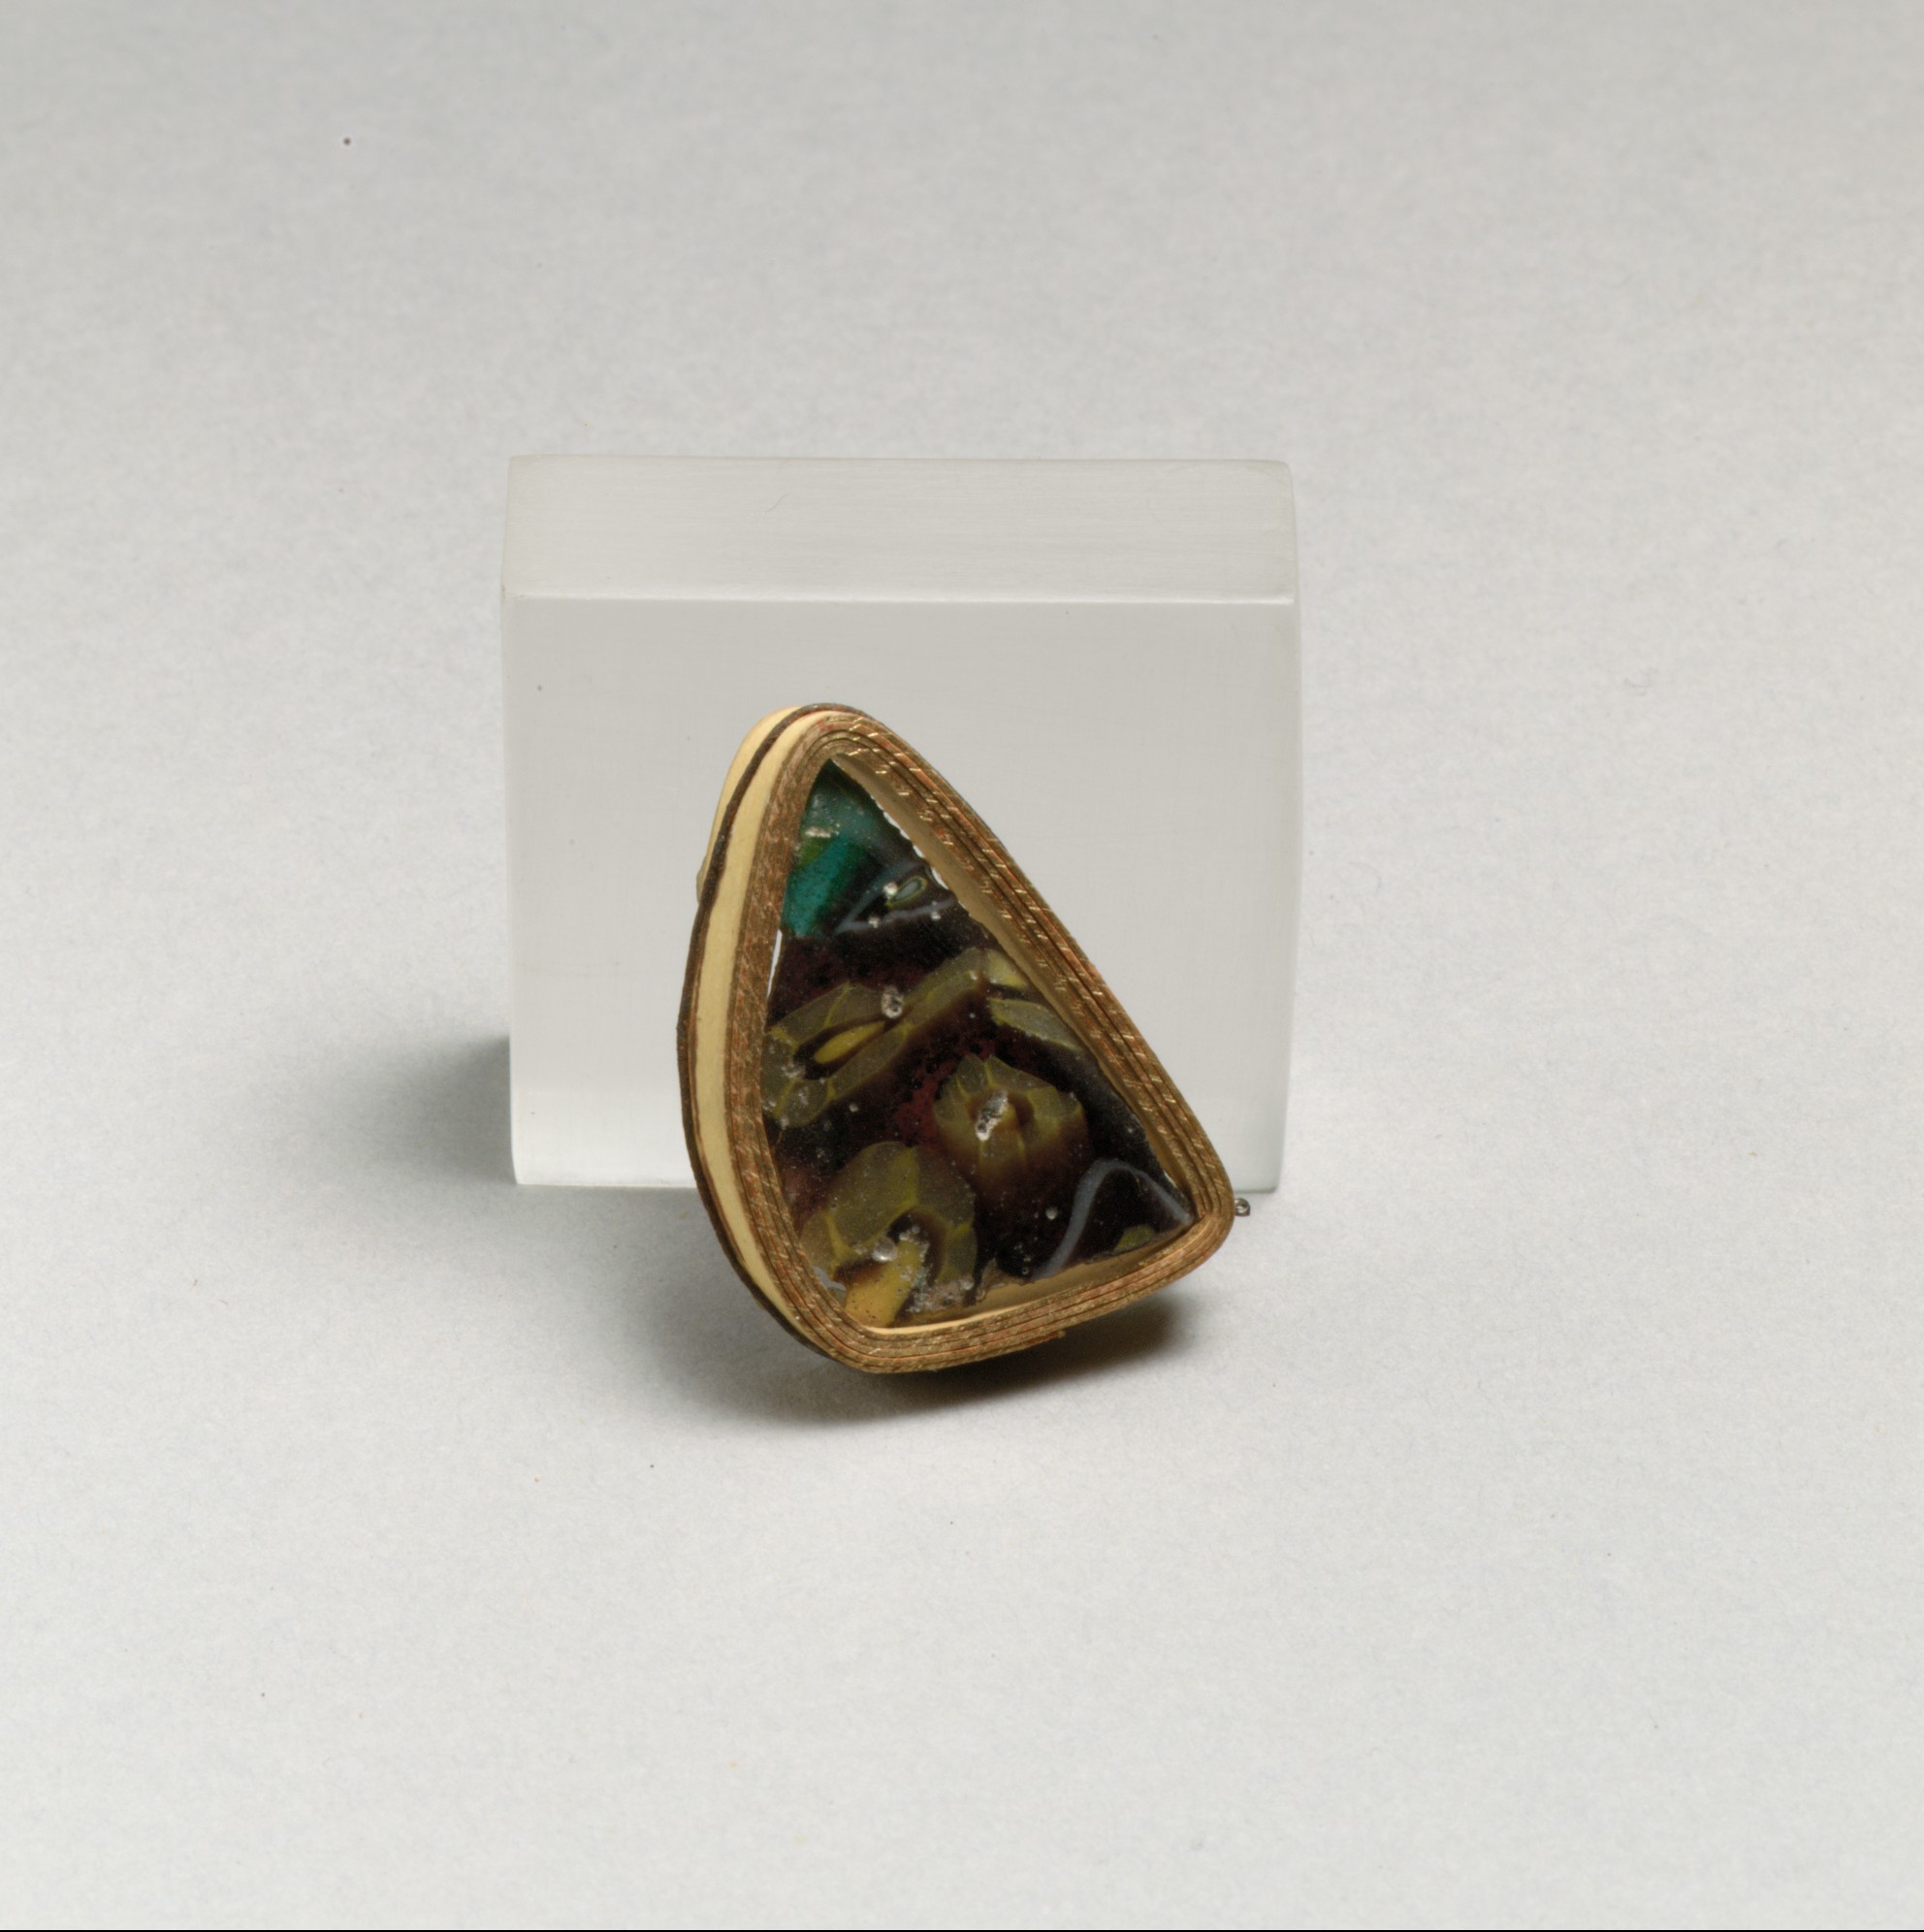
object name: fragment, mosaic bowl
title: Glass mosaic carinated bowl fragment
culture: roman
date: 34 BCE-33 CE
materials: glass